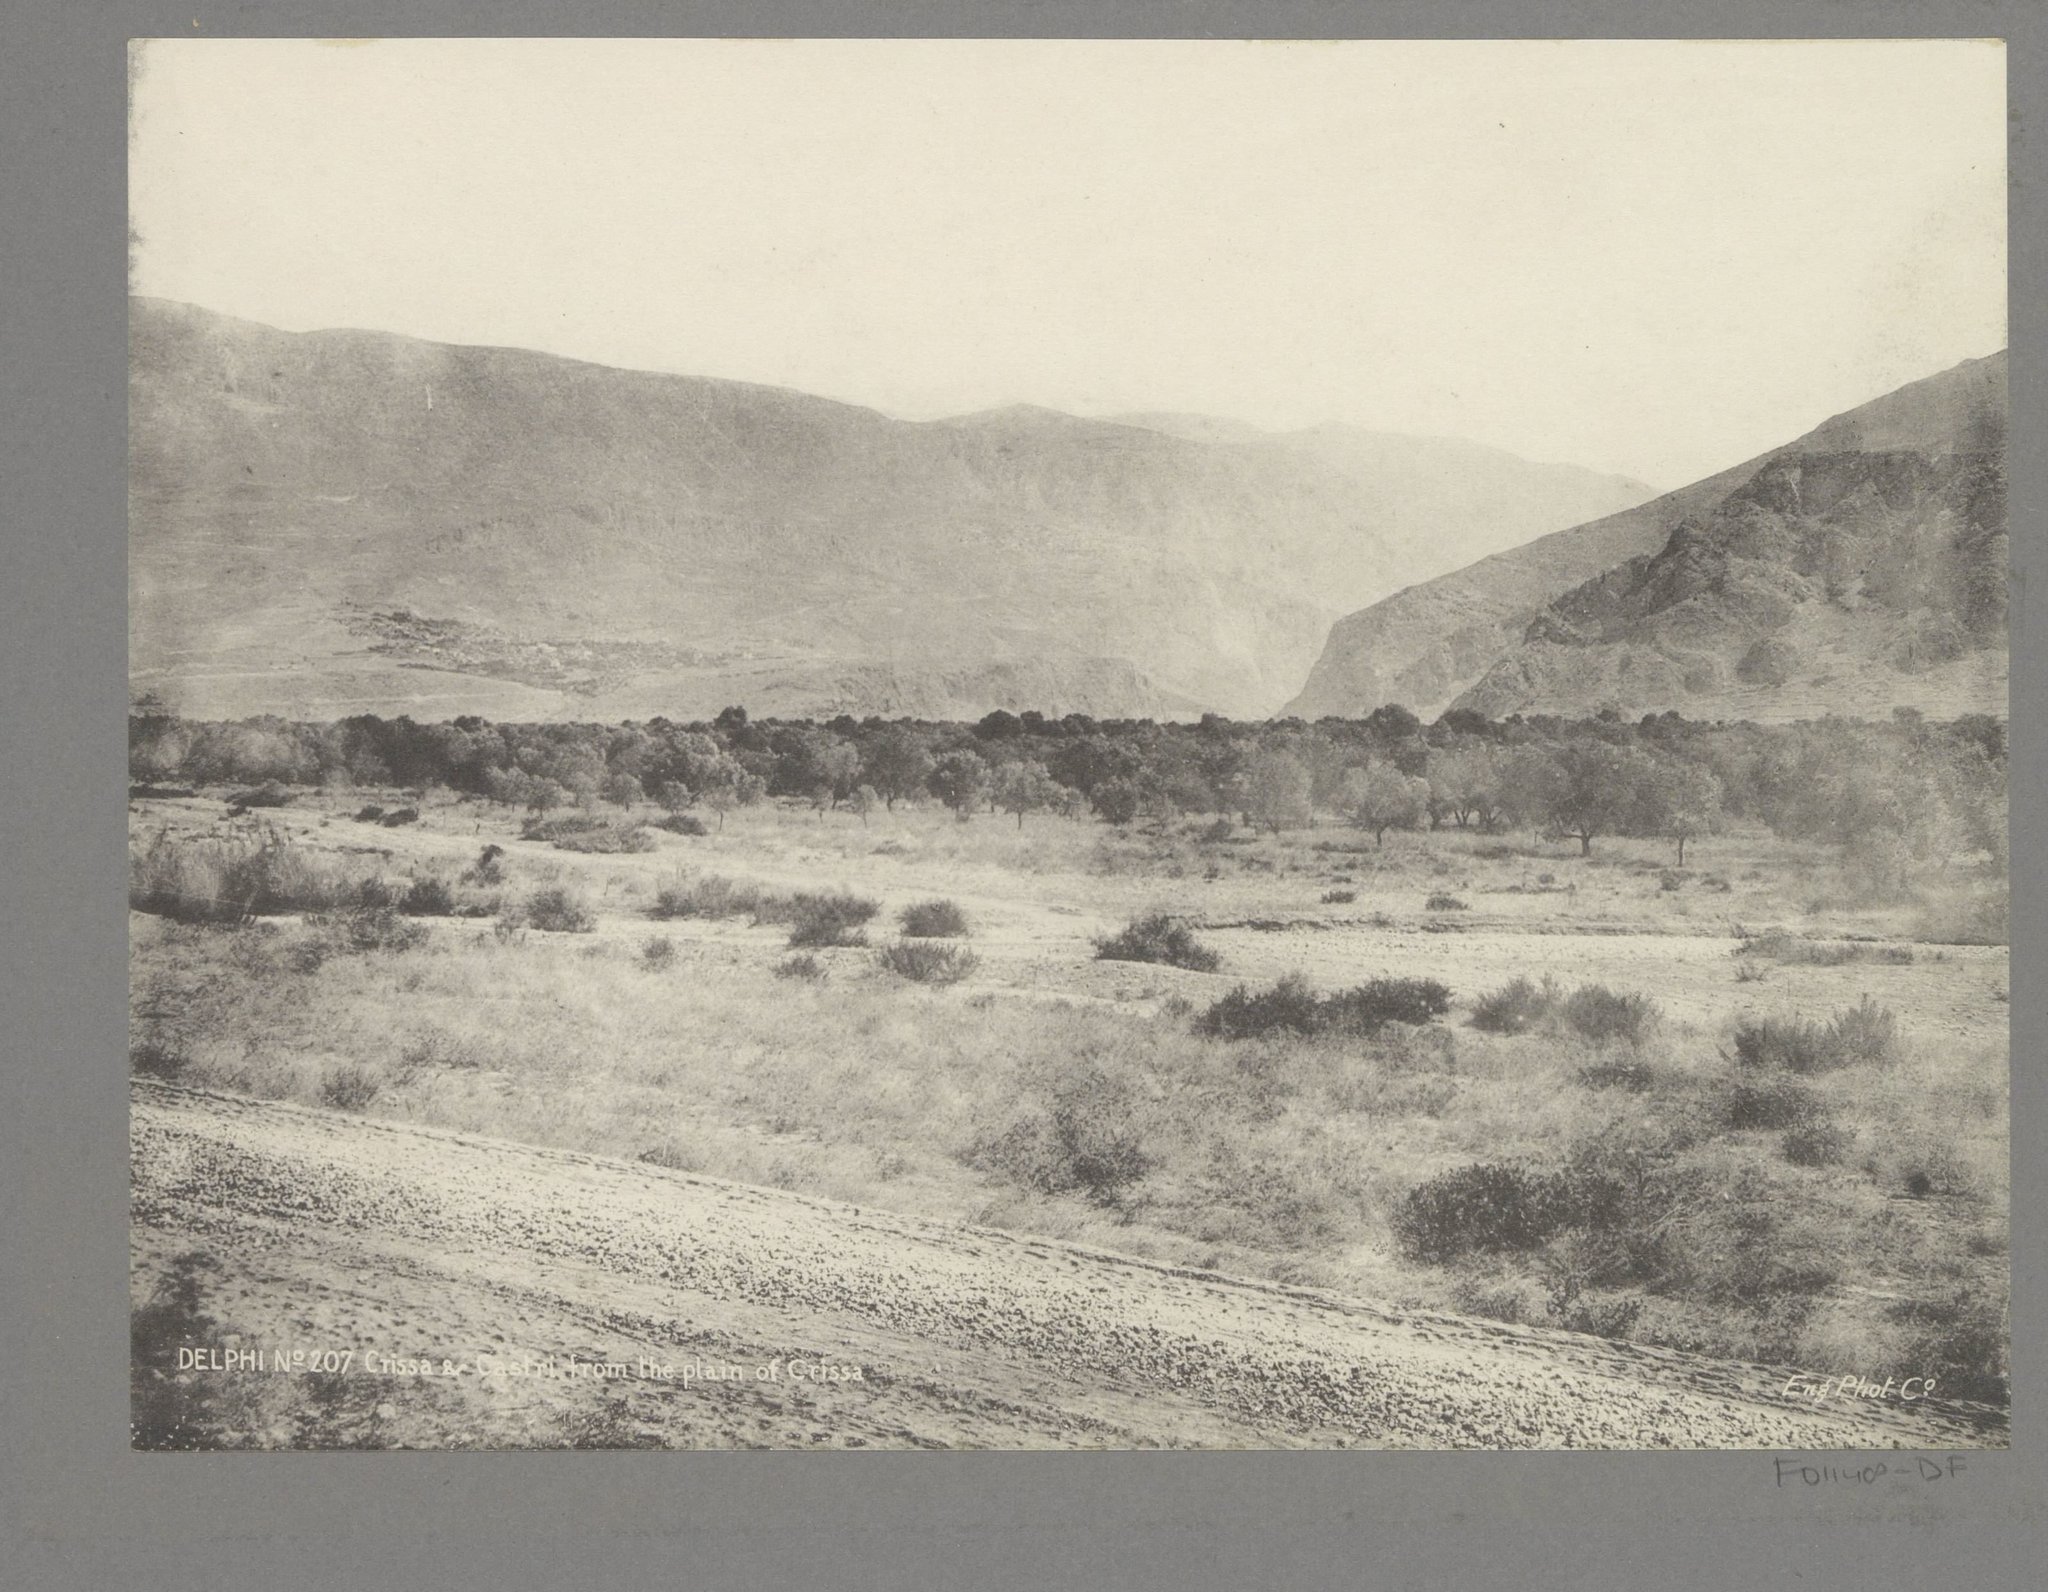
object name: photograph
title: Gezicht op de vlakte van Crissa en Castri bij Delphi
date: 1895-1905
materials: paper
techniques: photograph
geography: delphi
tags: trees: olive-tree, plain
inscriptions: number: ‘207’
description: Onderdeel van Reisalbum met foto's van bezienswaardigheden in Griekenland en Egypte.